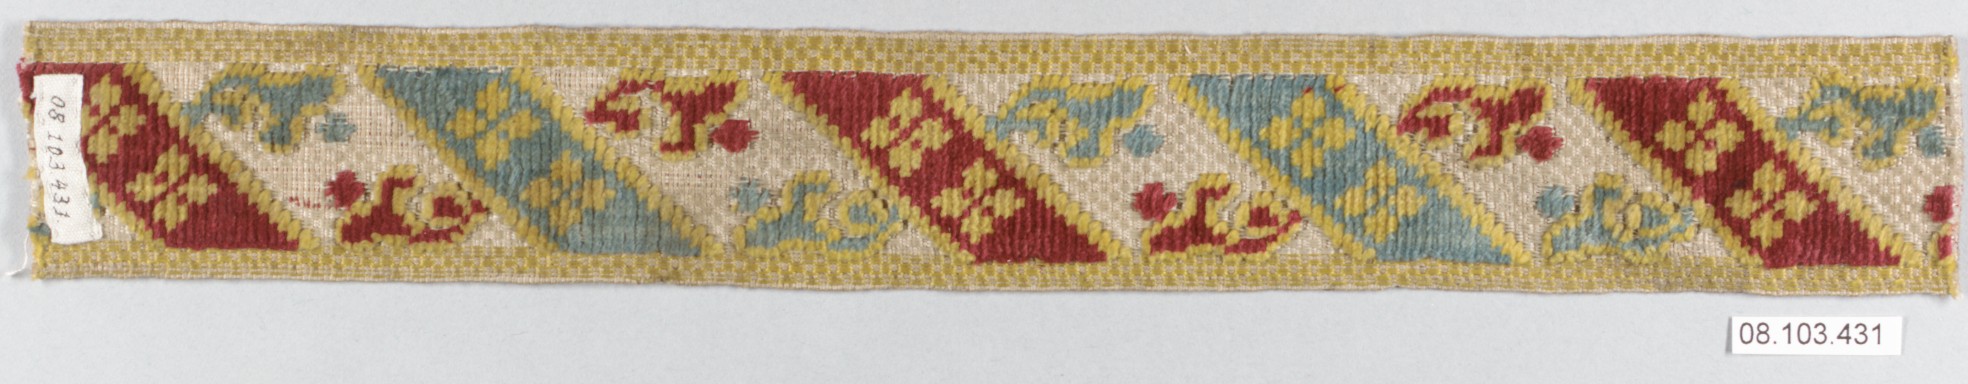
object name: galloon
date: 1701-1900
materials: silk